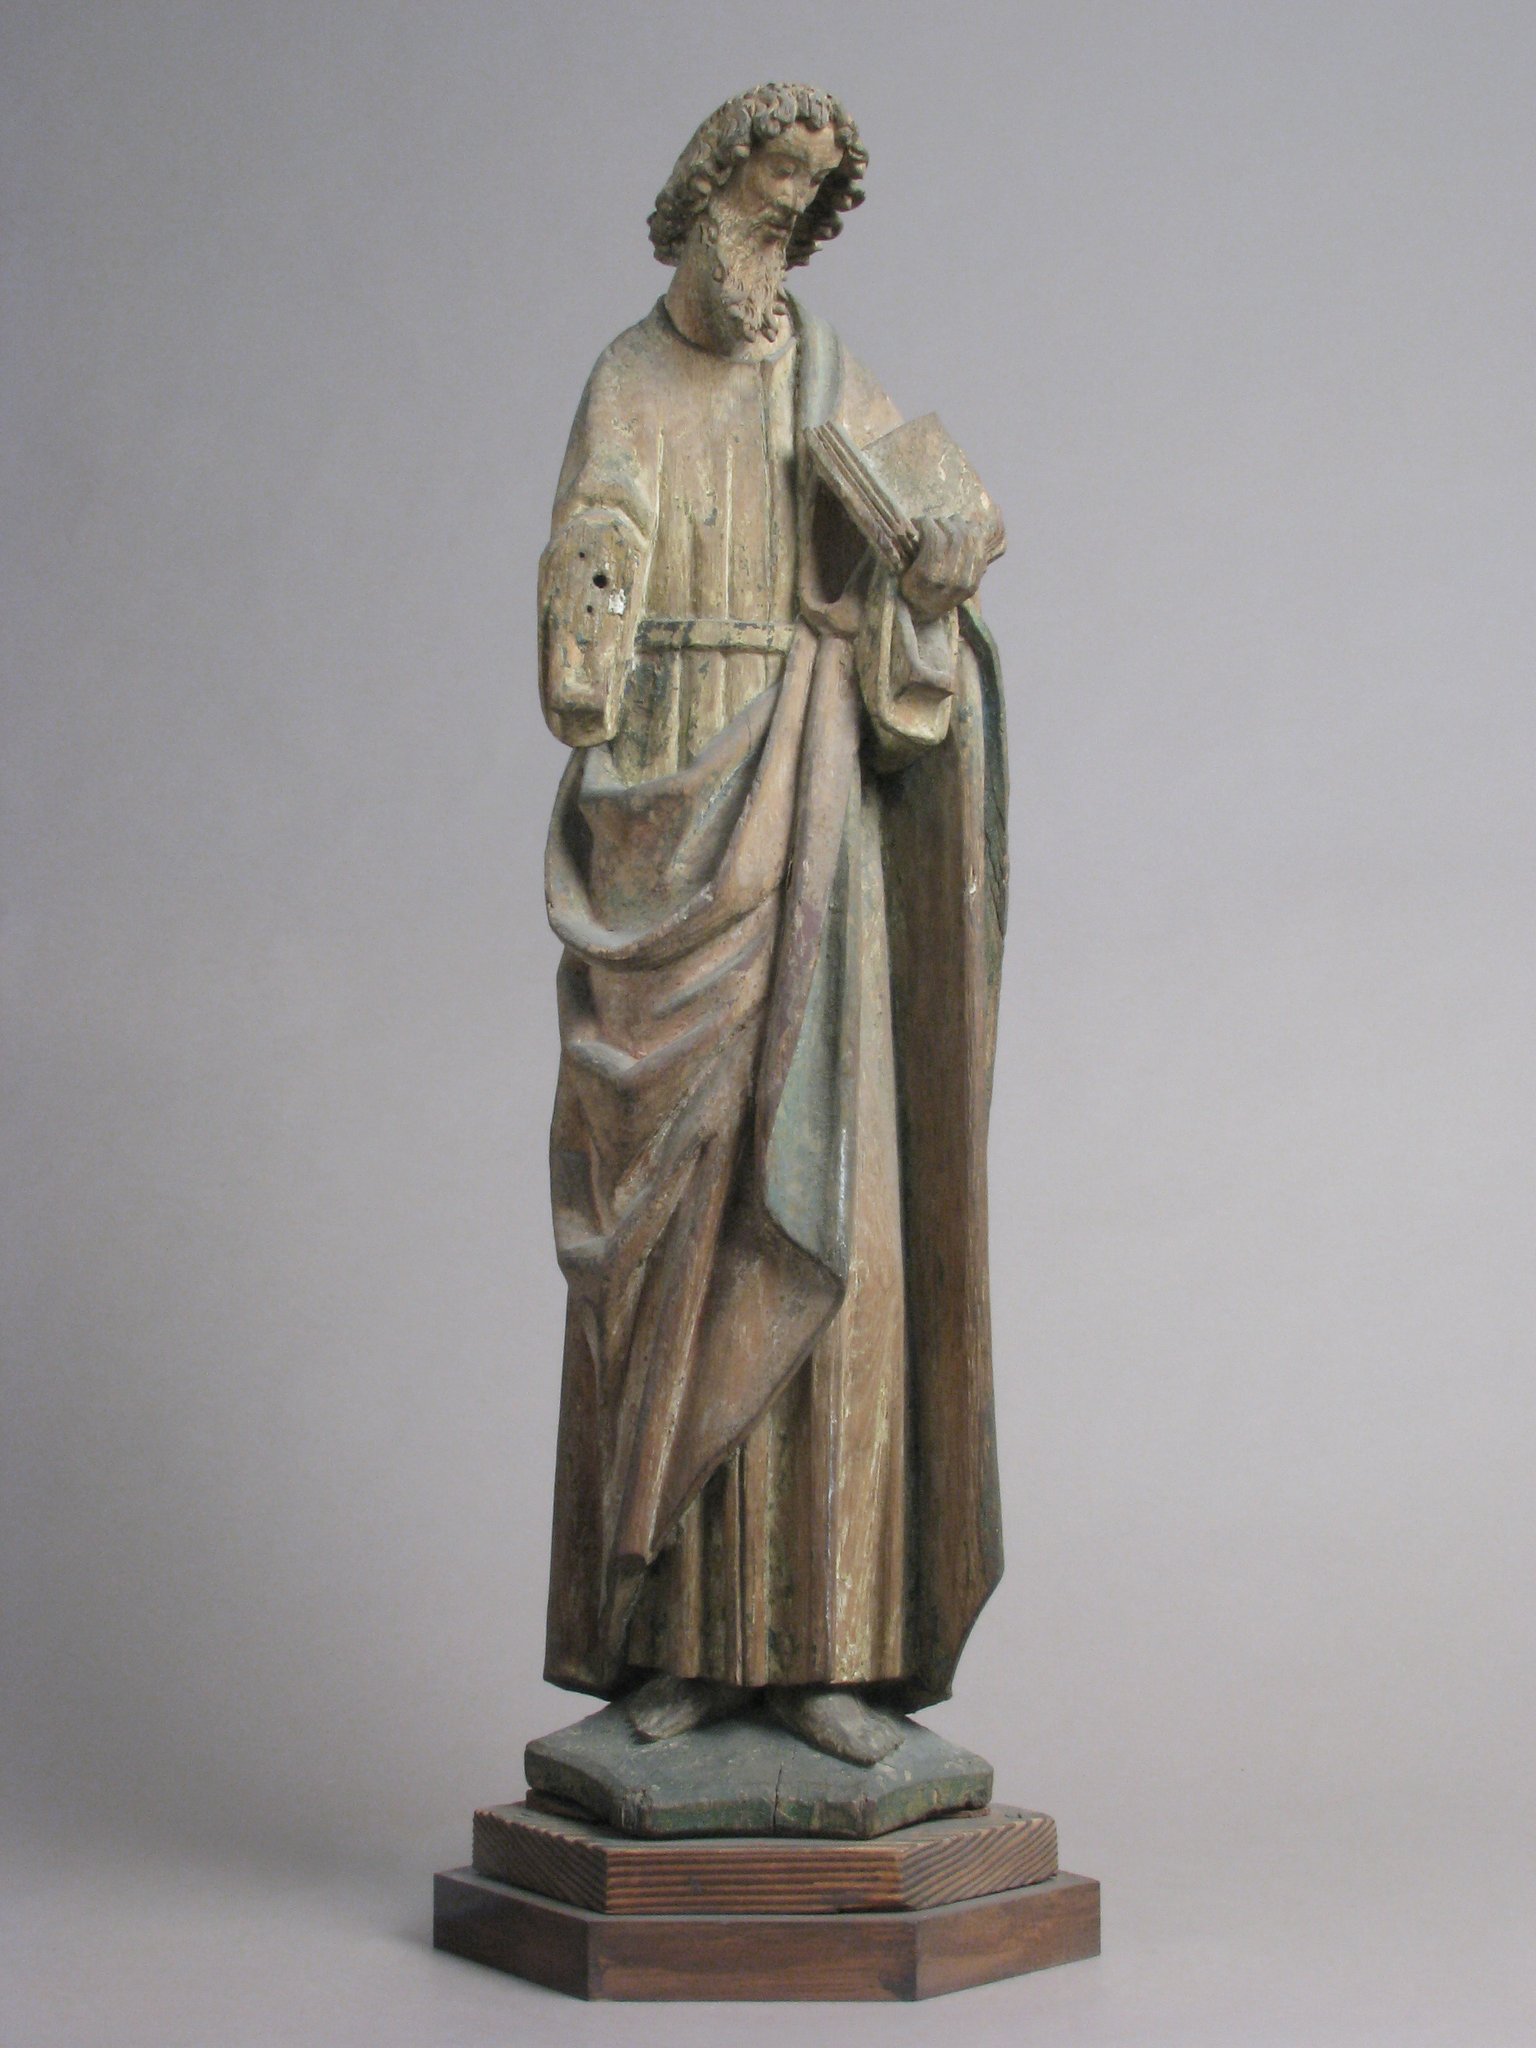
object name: statuette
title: Saint Matthias (?)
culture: dutch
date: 1500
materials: wood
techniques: gilding, polychromy